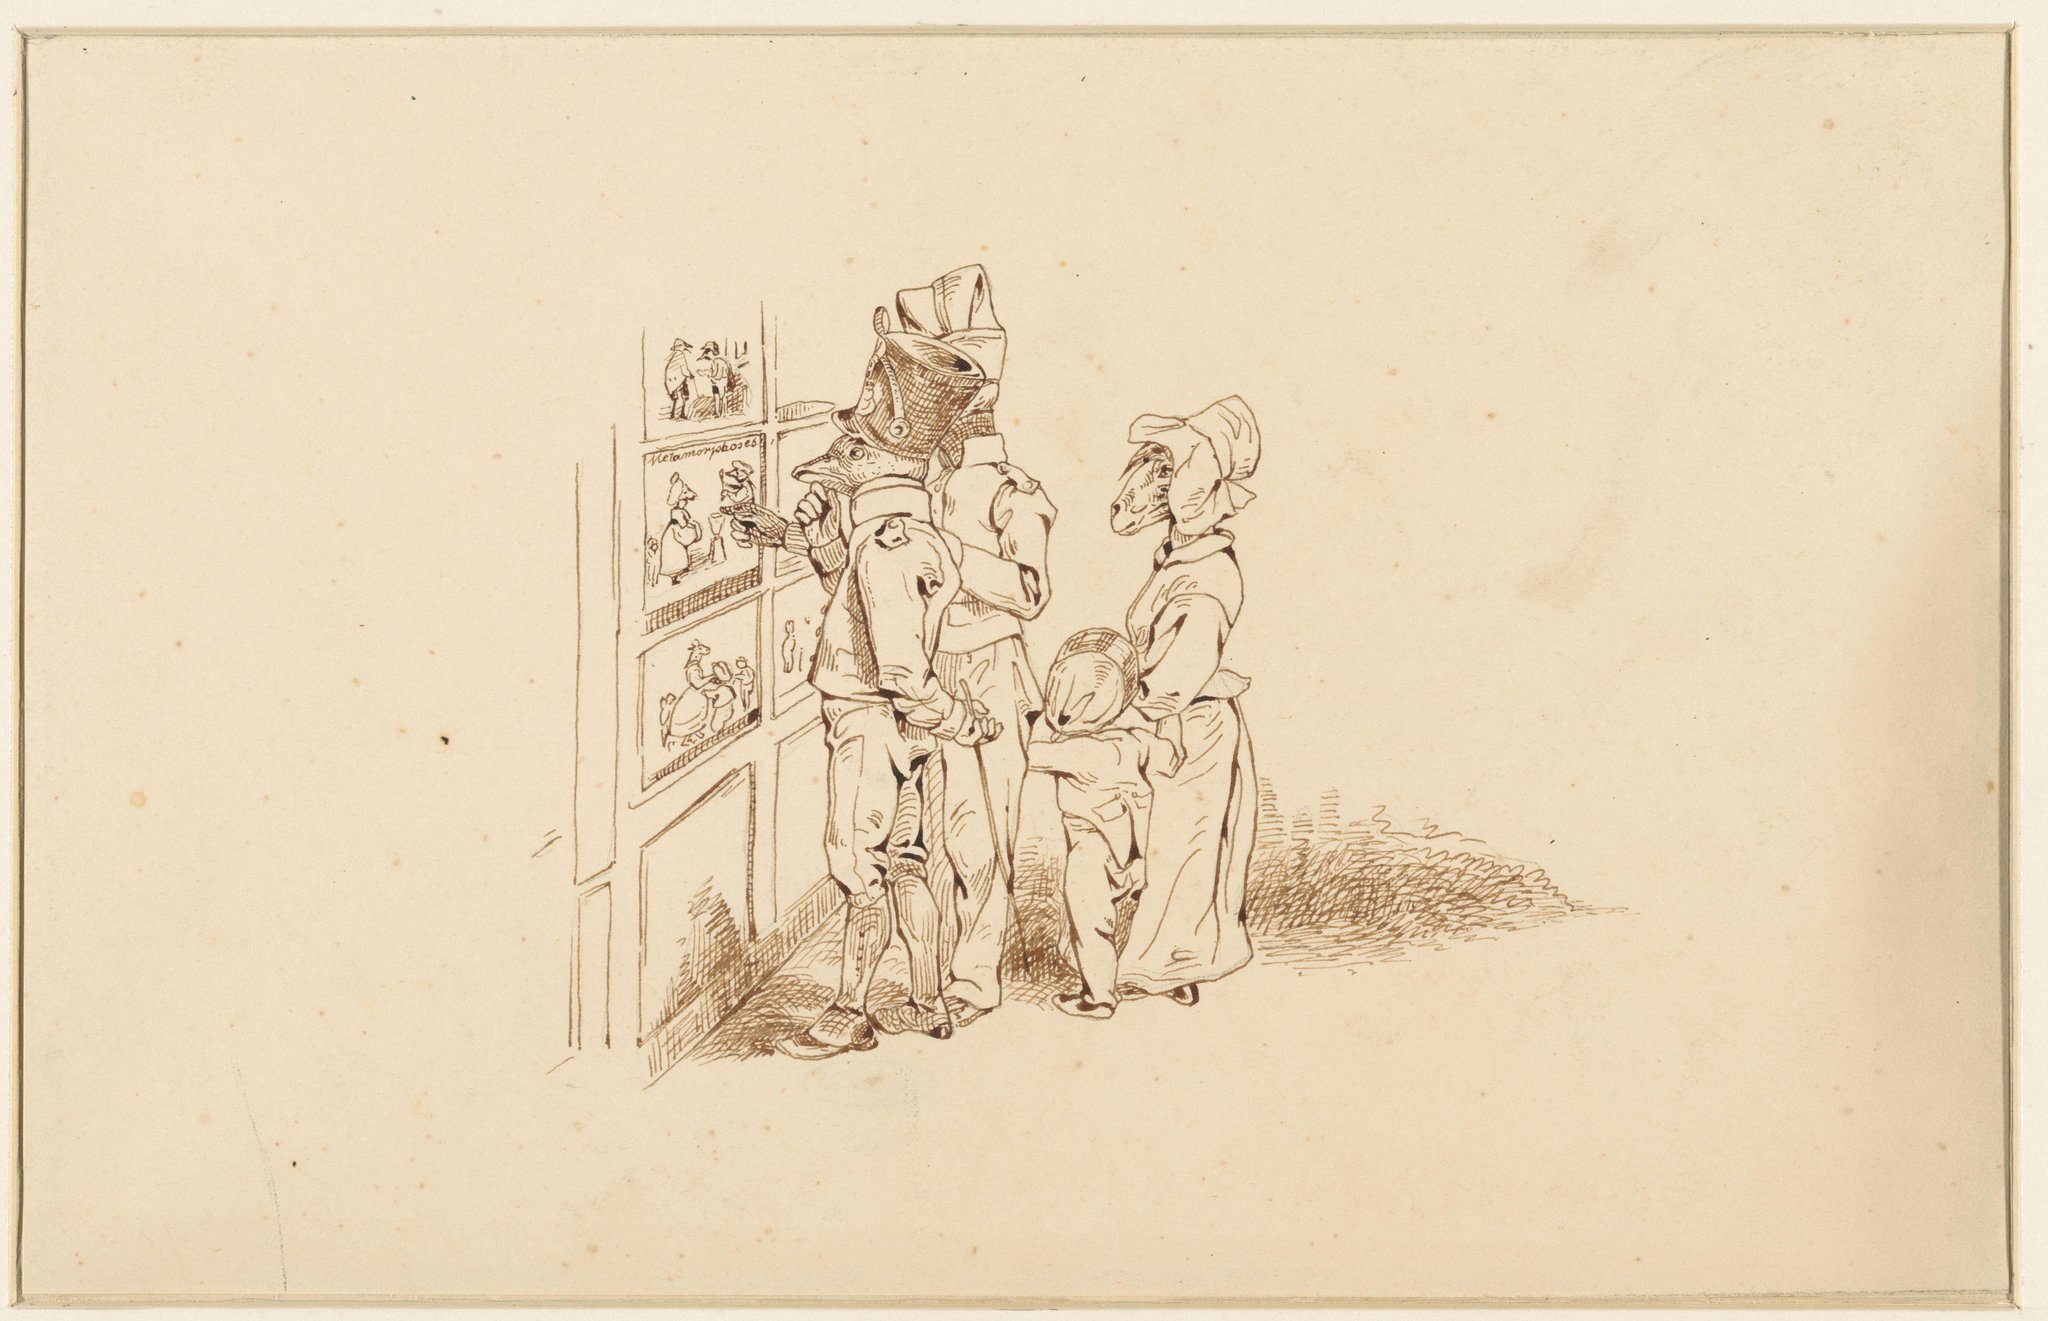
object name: drawing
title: Dierfabel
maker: wilhelm koller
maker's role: draughtsman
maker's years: 1829-1884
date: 1839-1884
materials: ink, paper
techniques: pen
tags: animals acting as human beings, temporary exhibition, 'salon'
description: Ontwerp voor een titelpagina van een boek met dierfabels: een echtpaar, waarvan de man (een vogel) in militair uniform is gekleed, en de vrouw (een ezelin) het zoontje aan de hand houdt, bekijkt in gezelschap van een tweede militair een tentoonstelling van in beeld gebrachte dierfabels. Boven een der afbeeldingen: metamorphoses.